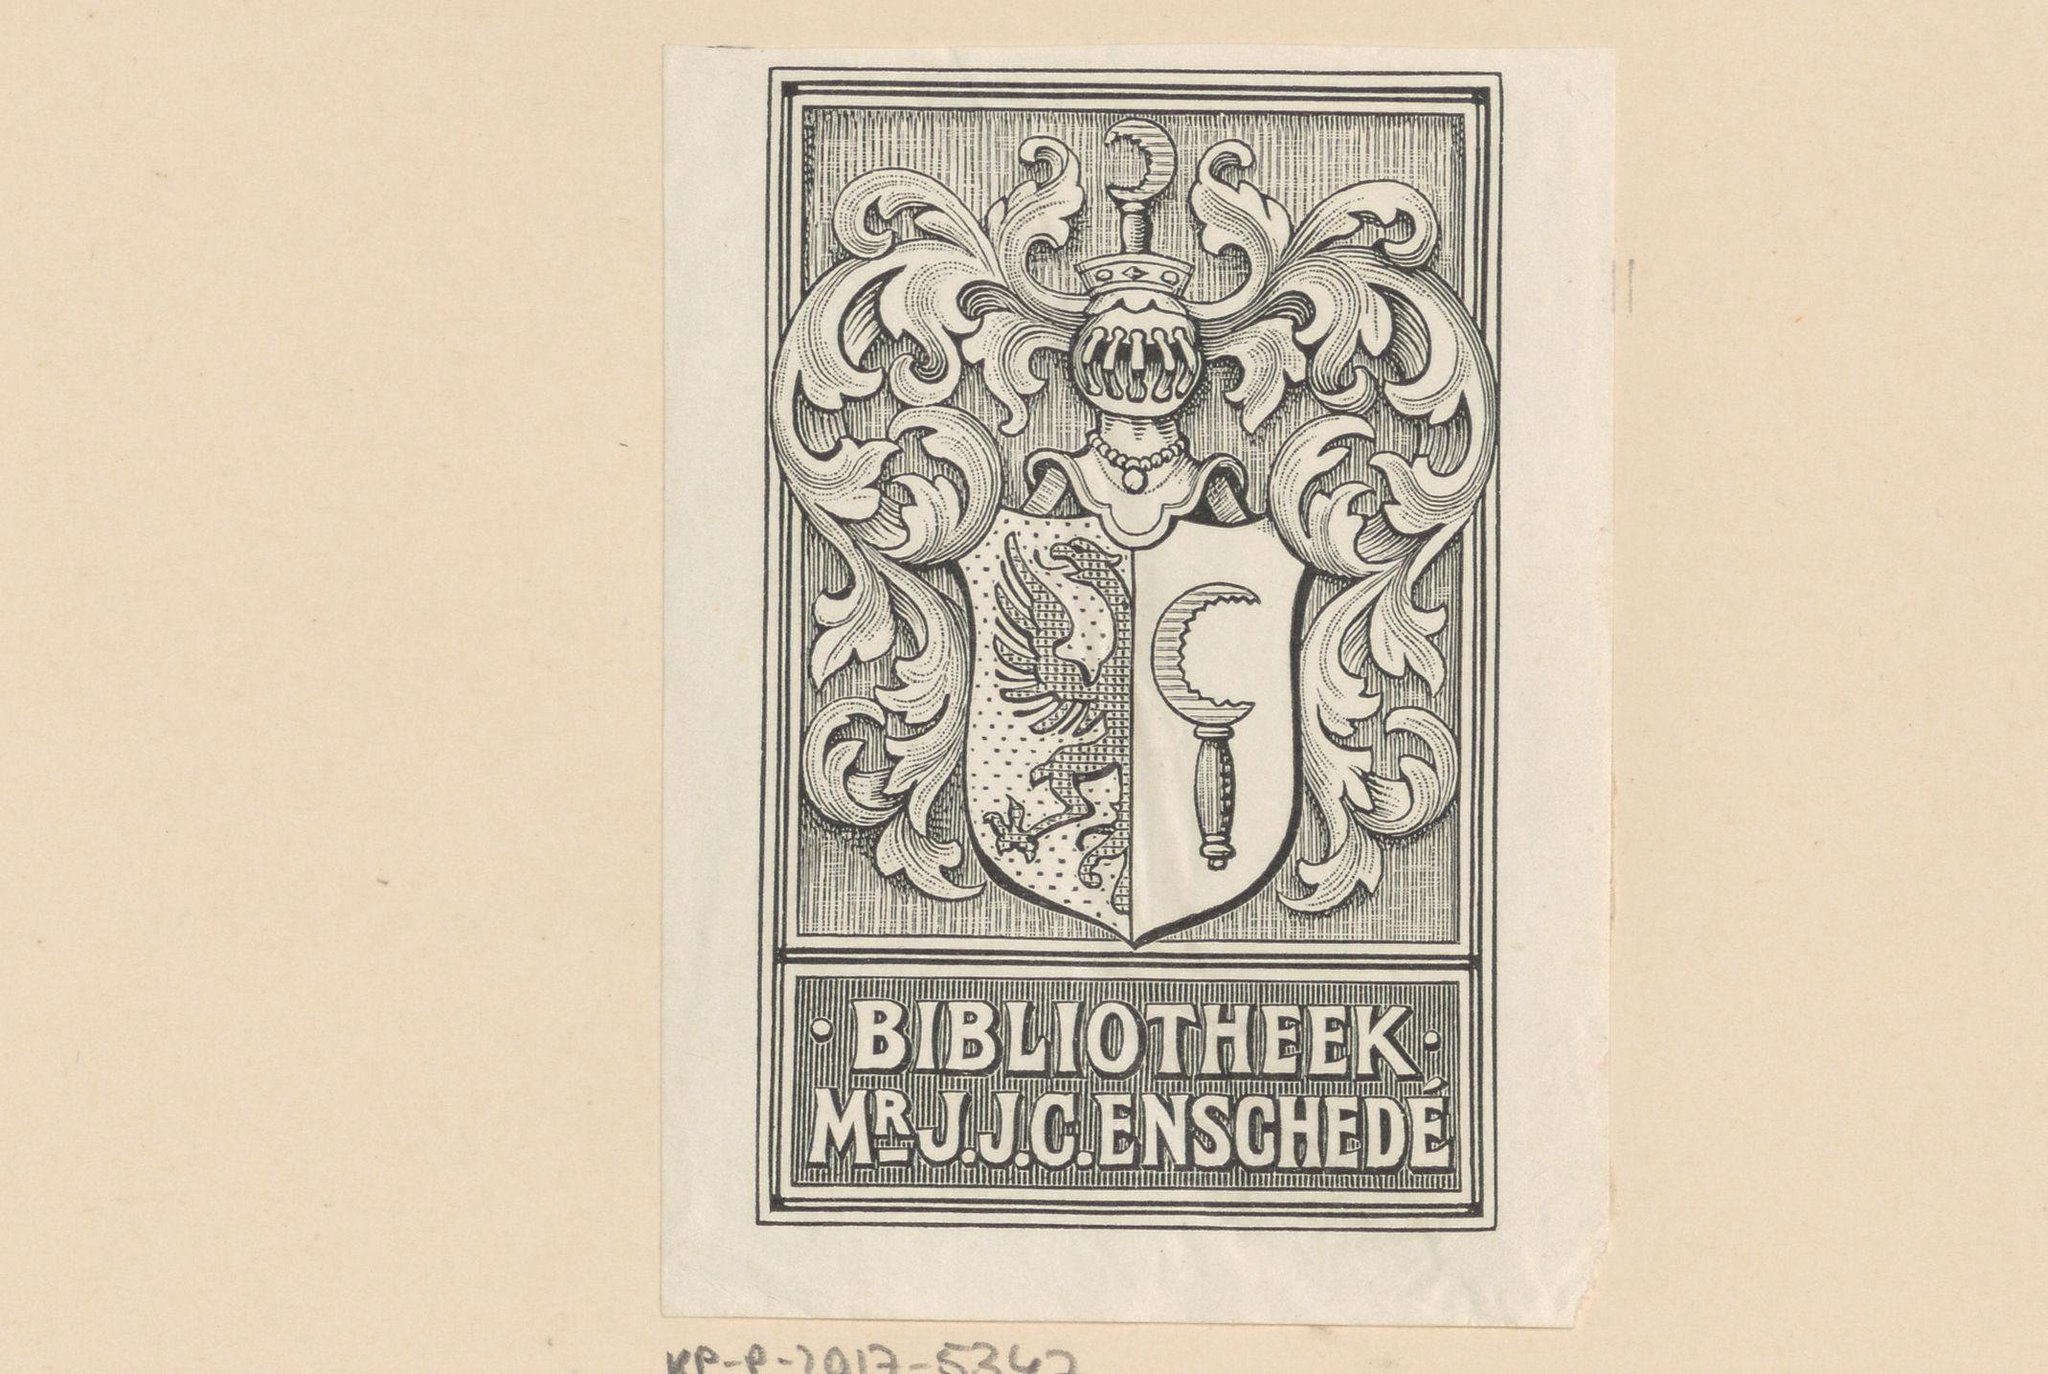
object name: bookplate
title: Ex libris van J.J.C. Enschedé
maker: Anonymous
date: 1870-1912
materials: paper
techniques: printing block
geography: netherlands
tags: armorial bearing, heraldry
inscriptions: inscription: ‘Rietstap, 617.’